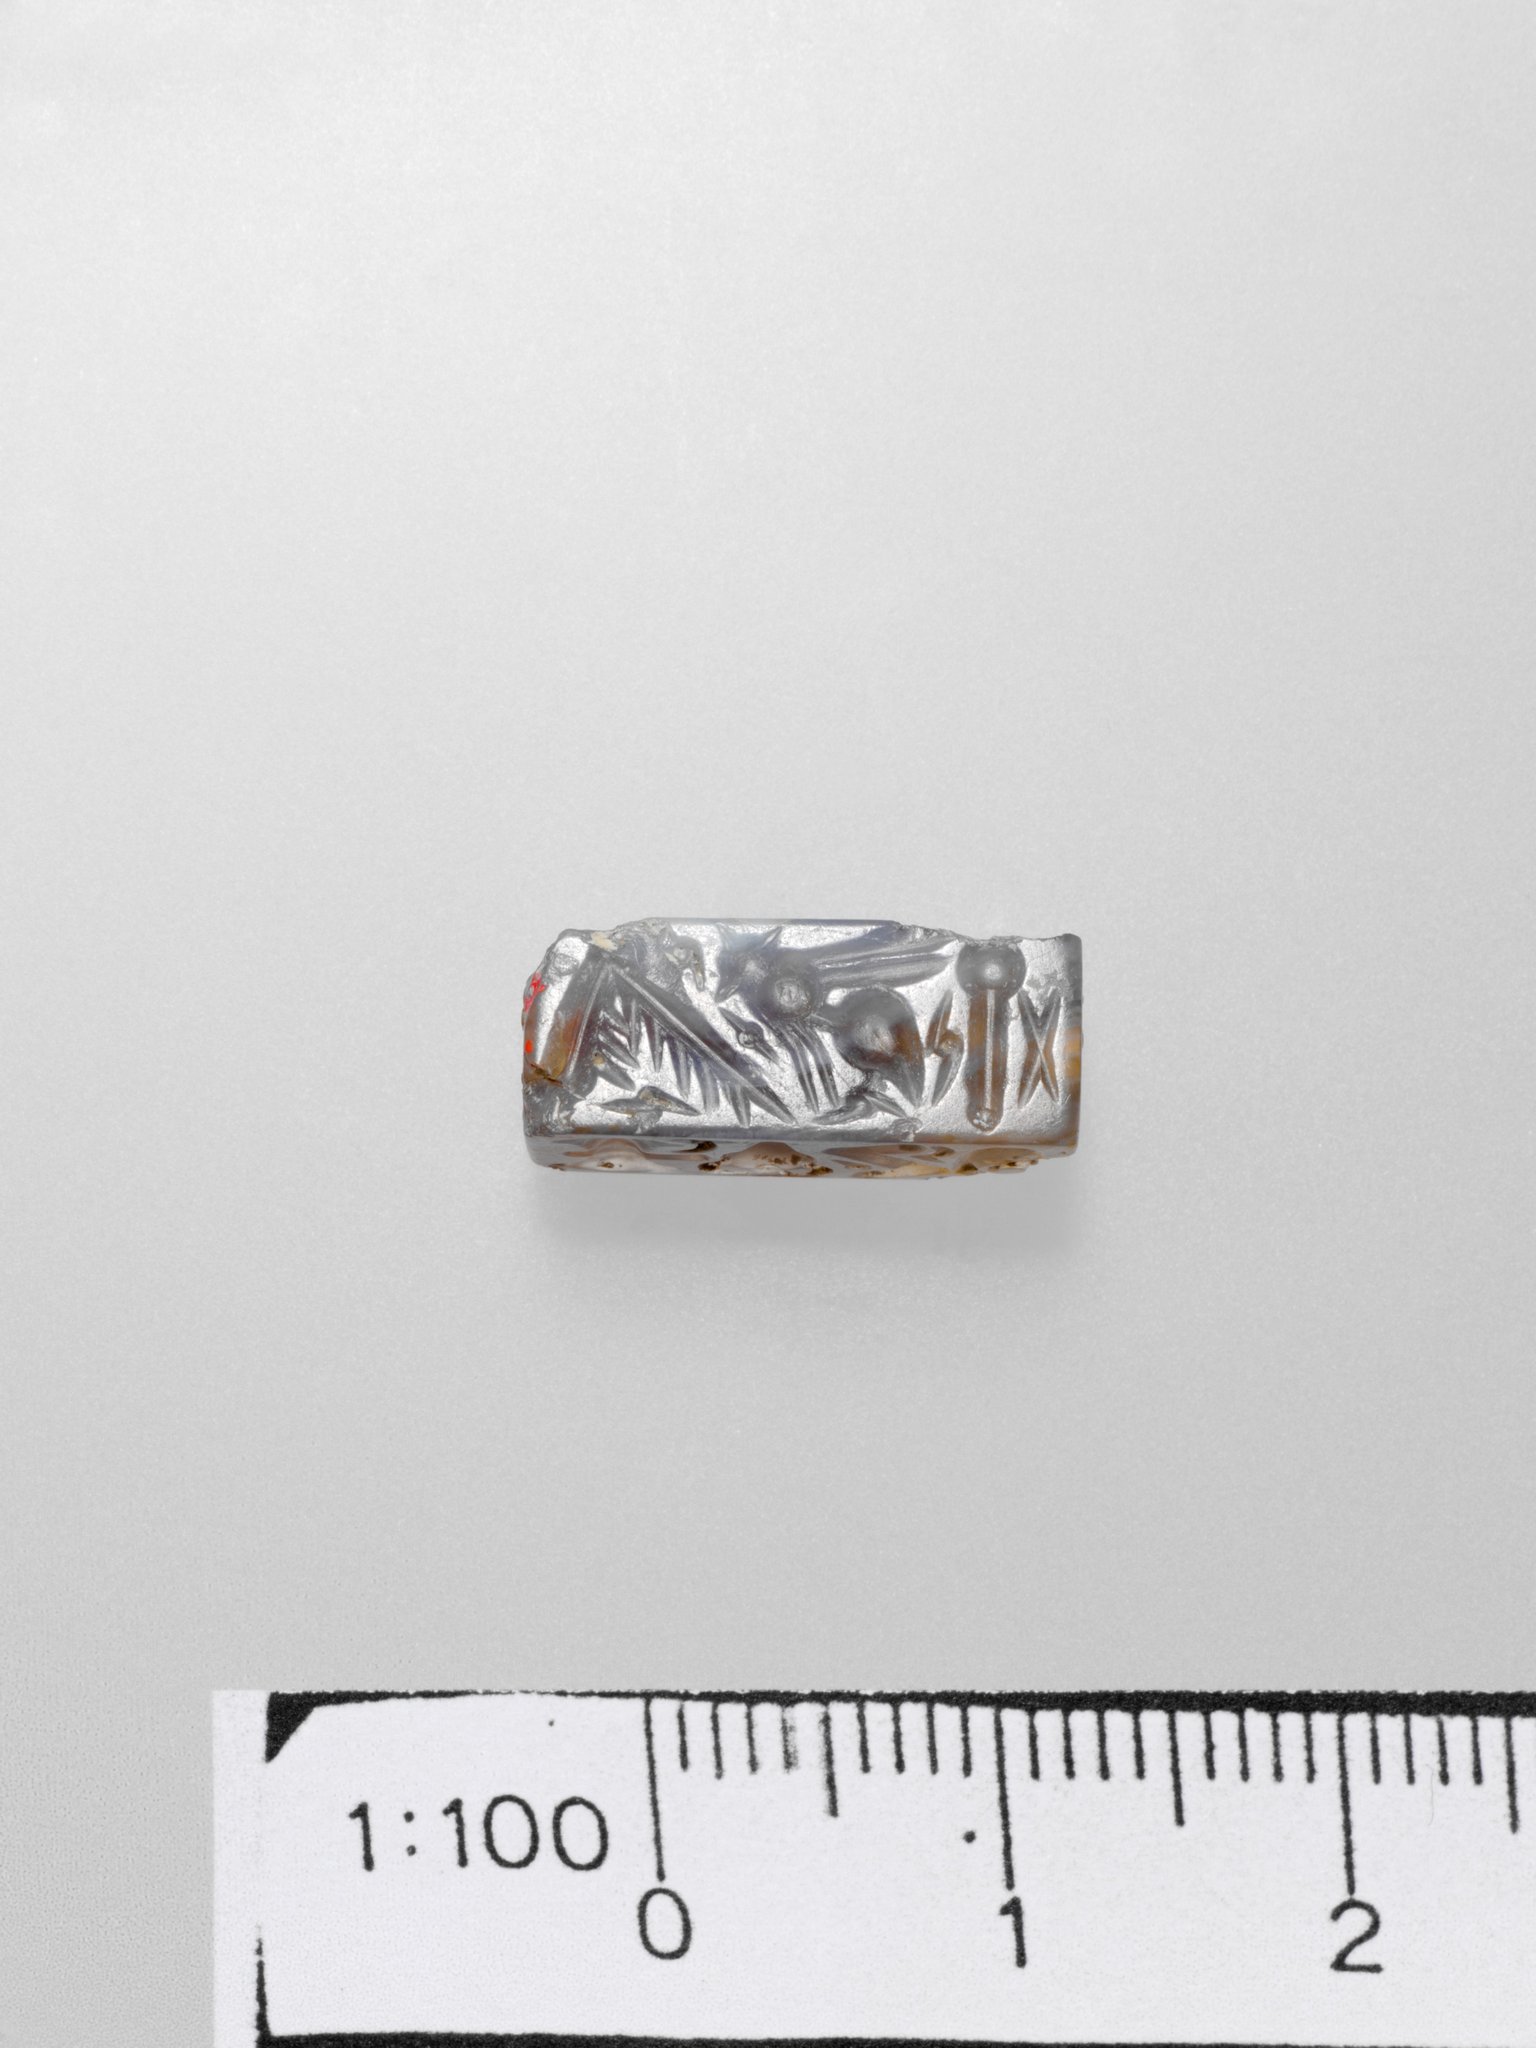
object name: prism, rectangular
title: Chalcedony rectangular prism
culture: minoan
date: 1900-1600 BCE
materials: stone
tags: hieroglyphs